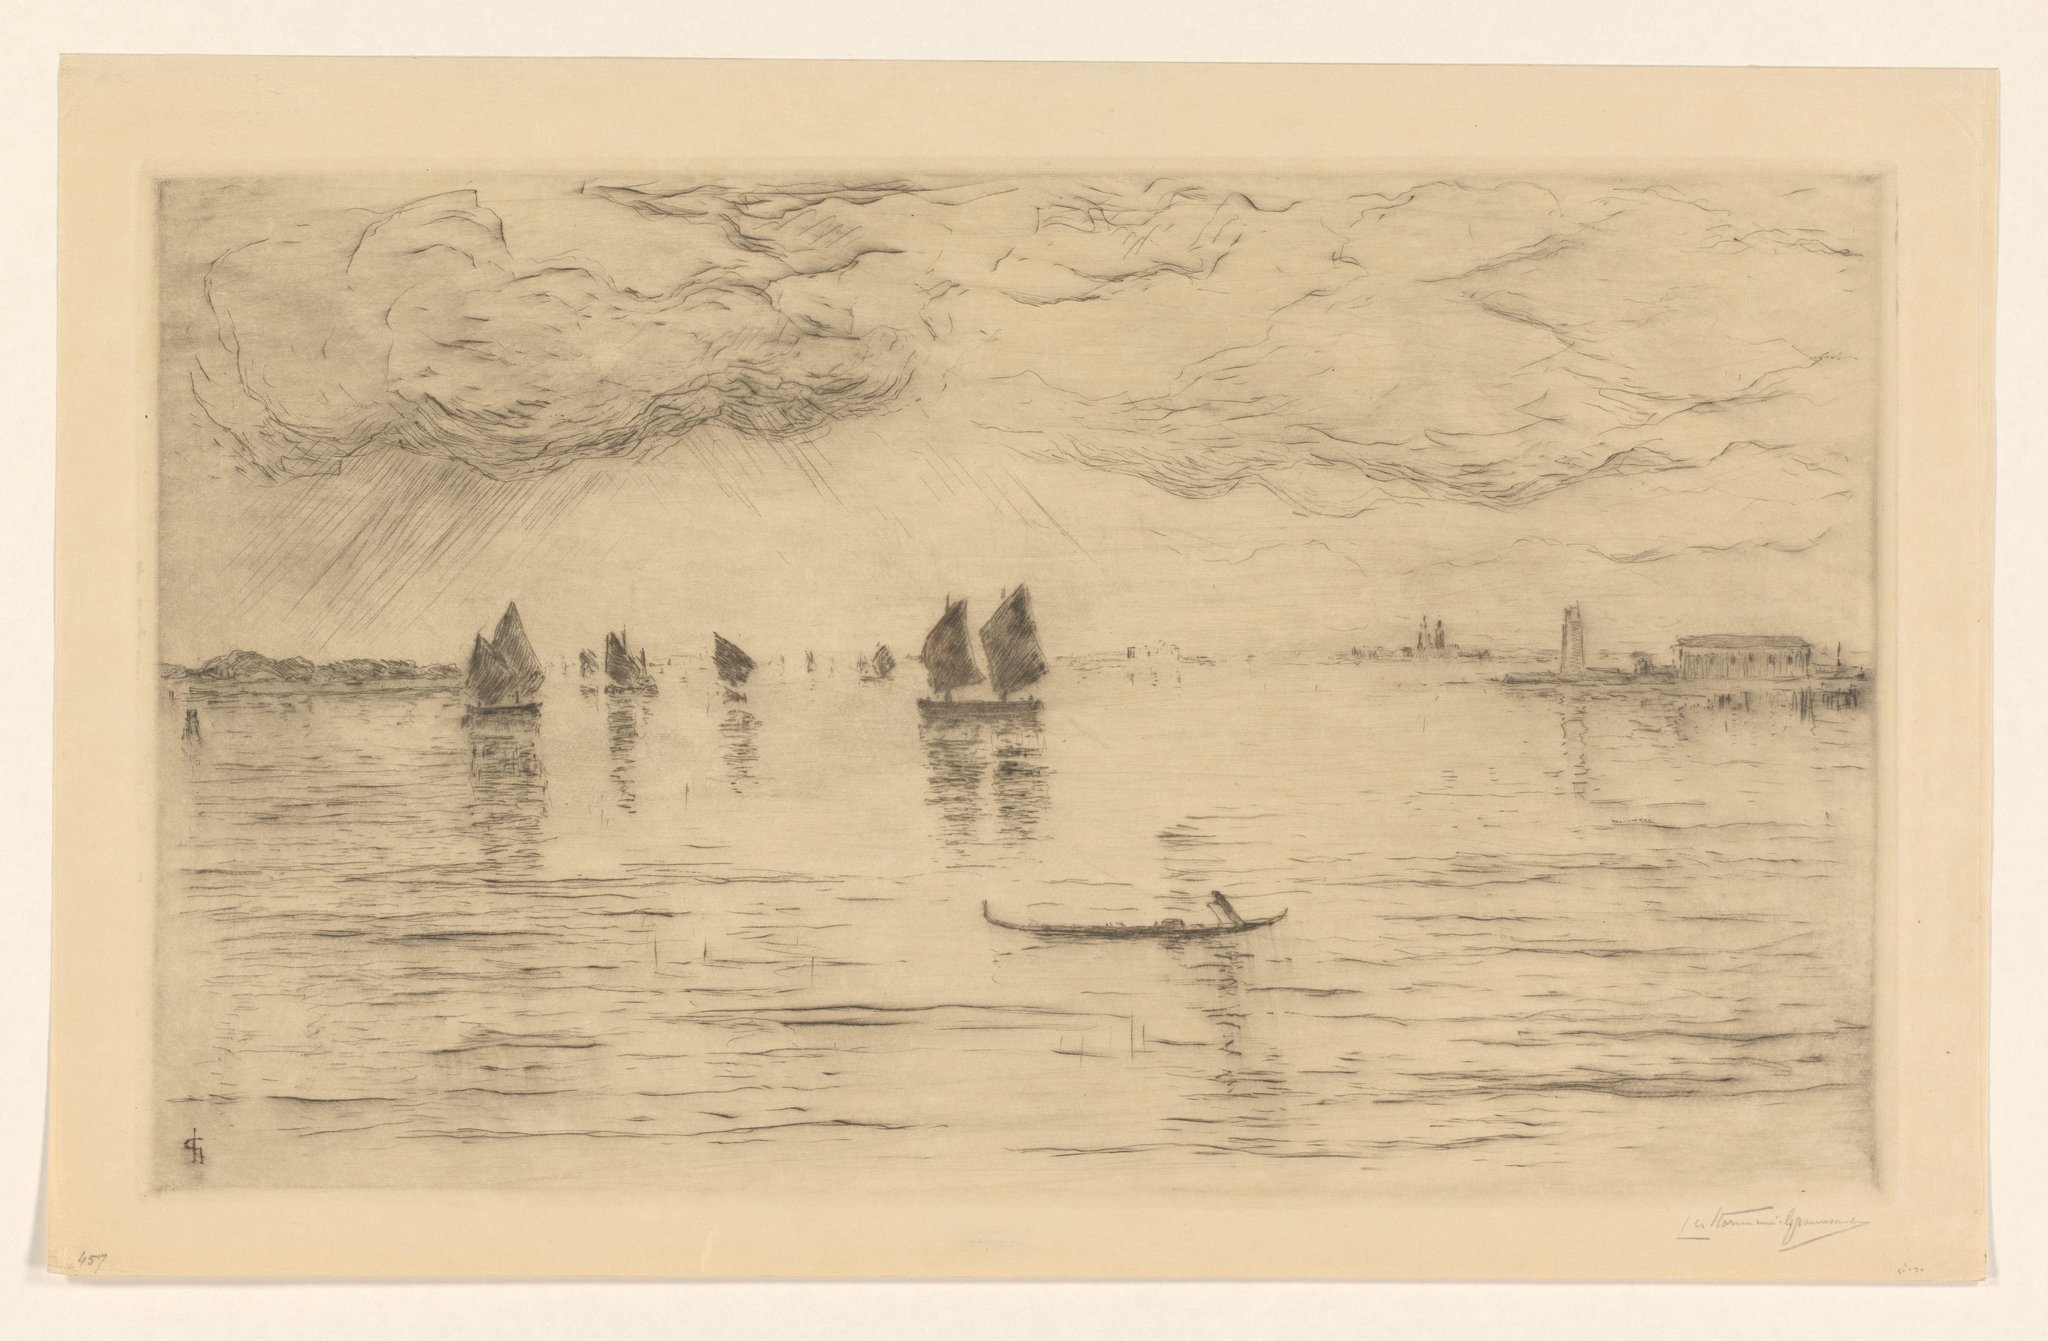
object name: print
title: Gondel en zeilboten op het water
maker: carel nicolaas storm van s-gravesande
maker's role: draughtsman, print maker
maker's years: 1841-1924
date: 1851-1924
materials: paper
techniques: drypoint, intaglio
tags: sailing-ship, sailing-boat, gondola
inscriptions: collector's mark: Lugt 2228